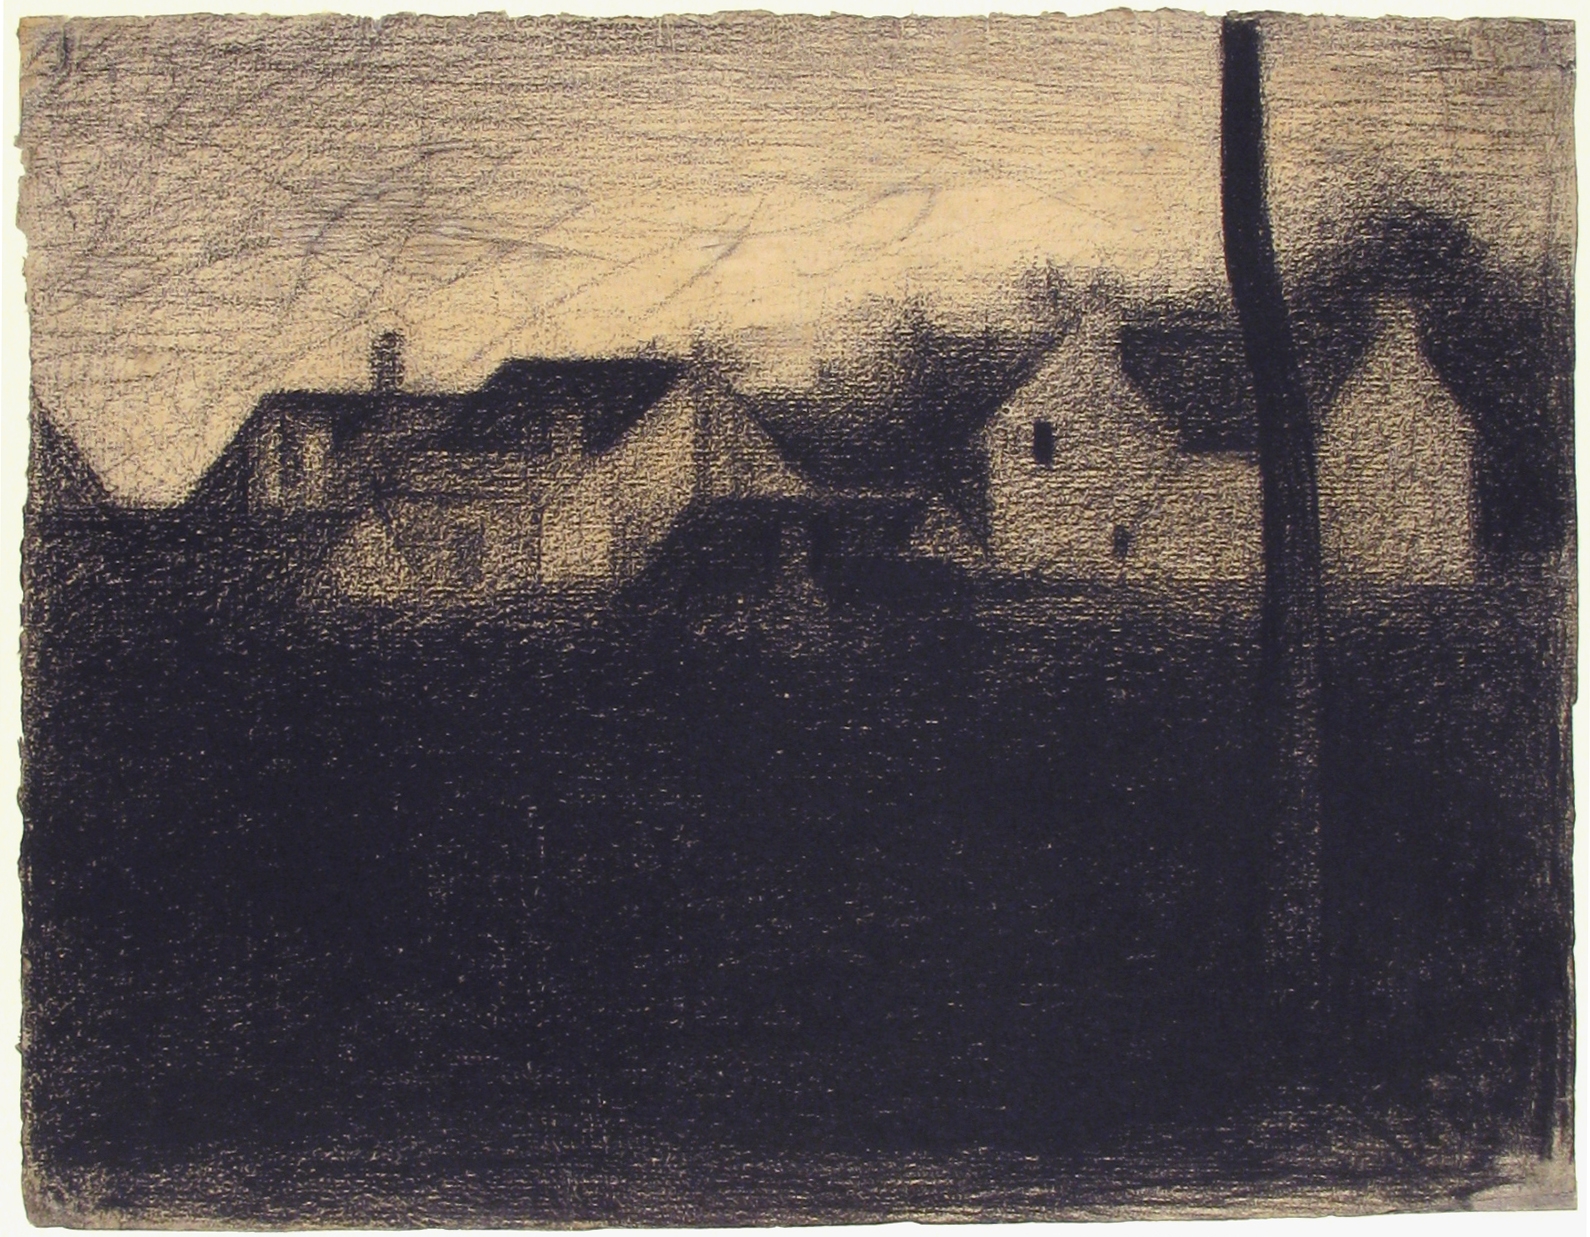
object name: drawing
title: Landscape with Houses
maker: georges seurat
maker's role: artist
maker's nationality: french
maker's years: 1859-1891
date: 1881-1882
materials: crayon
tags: houses,landscapes